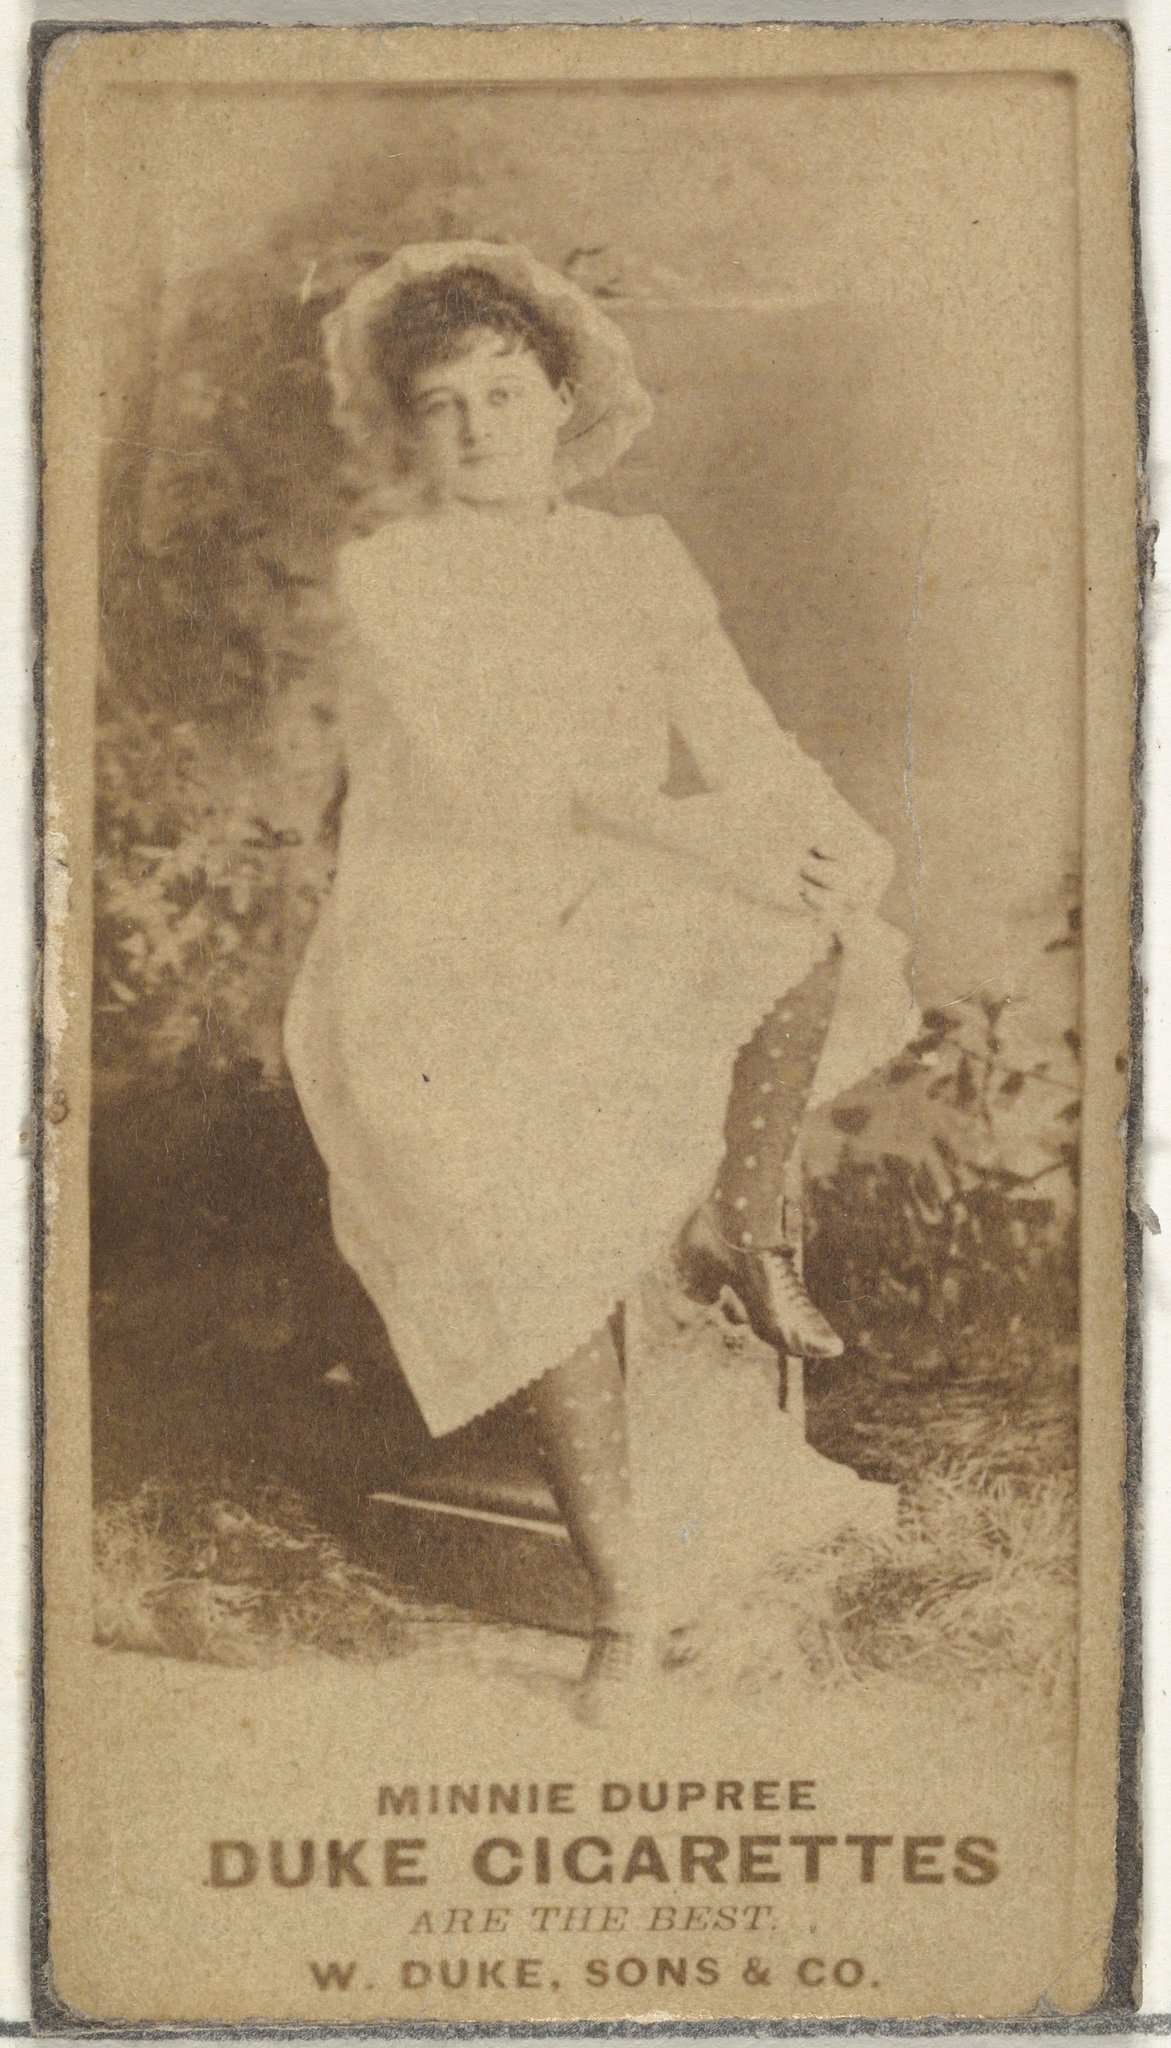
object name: photograph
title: Minni Dupree, from the Actors and Actresses series (N145-7) issued by Duke Sons & Co. to promote Duke Cigarettes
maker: w. duke, sons & co.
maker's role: publisher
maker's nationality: american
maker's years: 1870-1920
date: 1880-1889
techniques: albumen silver print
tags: portraits,women,actresses